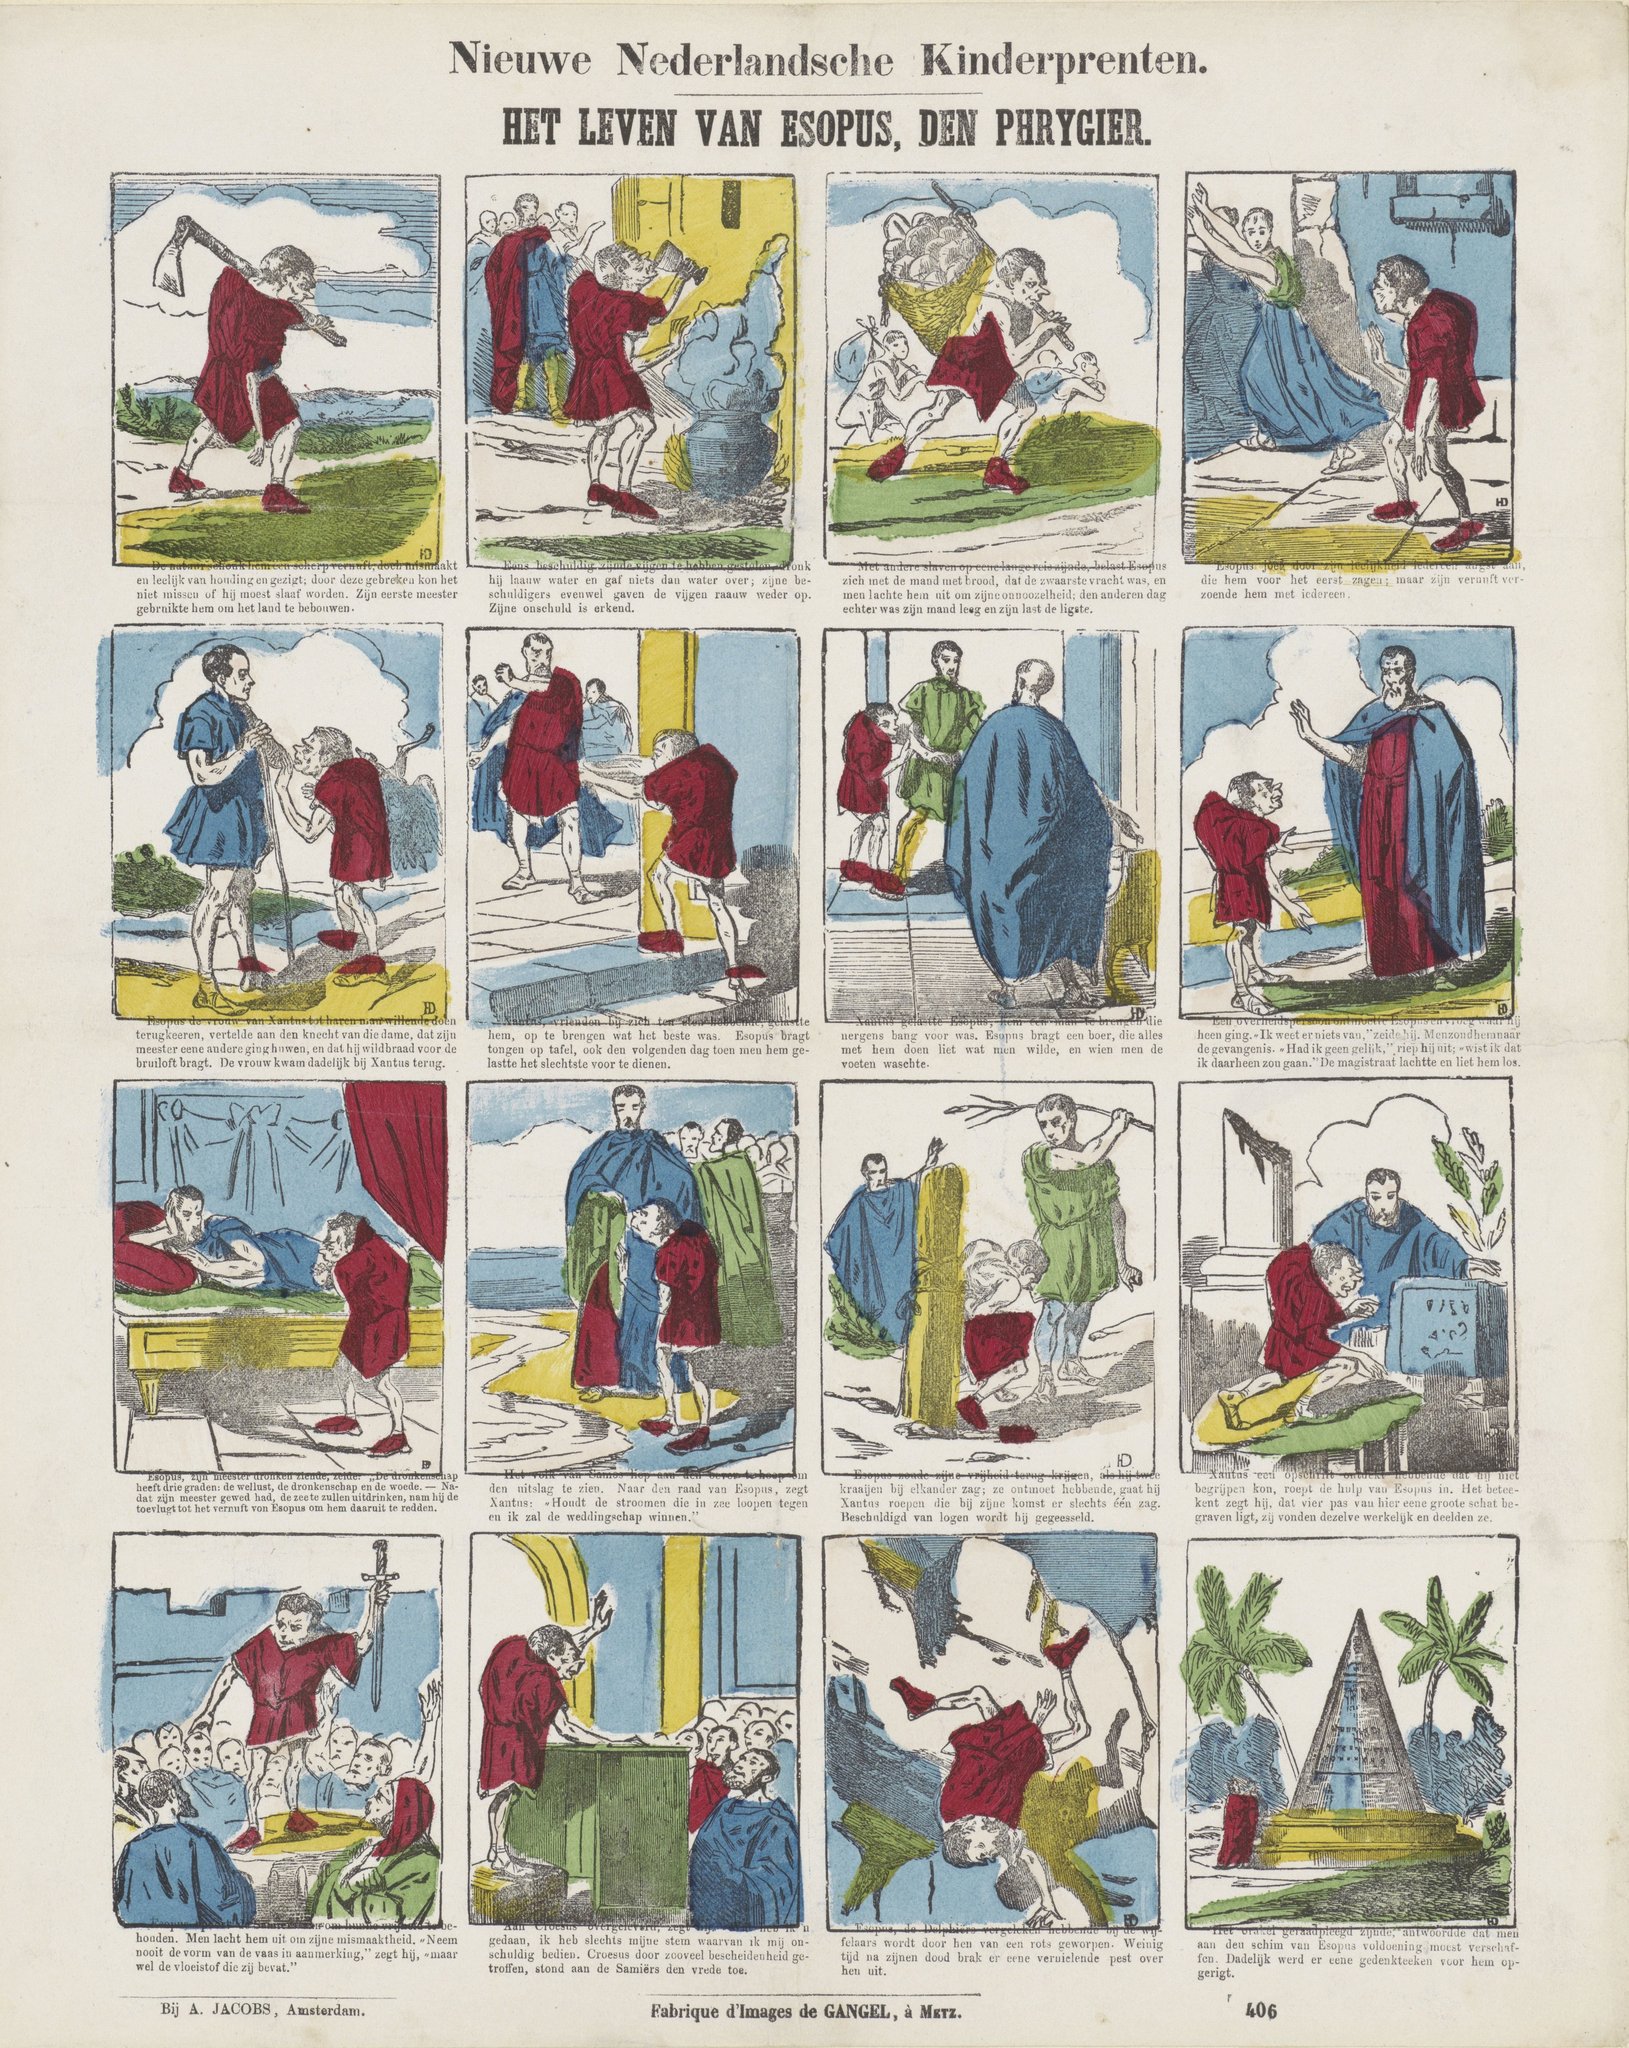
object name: print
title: Nieuwe Nederlandsche kinderprenten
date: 1840-1868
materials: paper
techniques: hand coloring, letterpress printing, lithograph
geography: metz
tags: hunchback, tales and fairy tales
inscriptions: collector's mark: Lugt 2760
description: Blad met 16 voorstellingen over het leven van Aesopus. Onder elke afbeelding een onderschrift. Genummerd rechtsonder: 406.